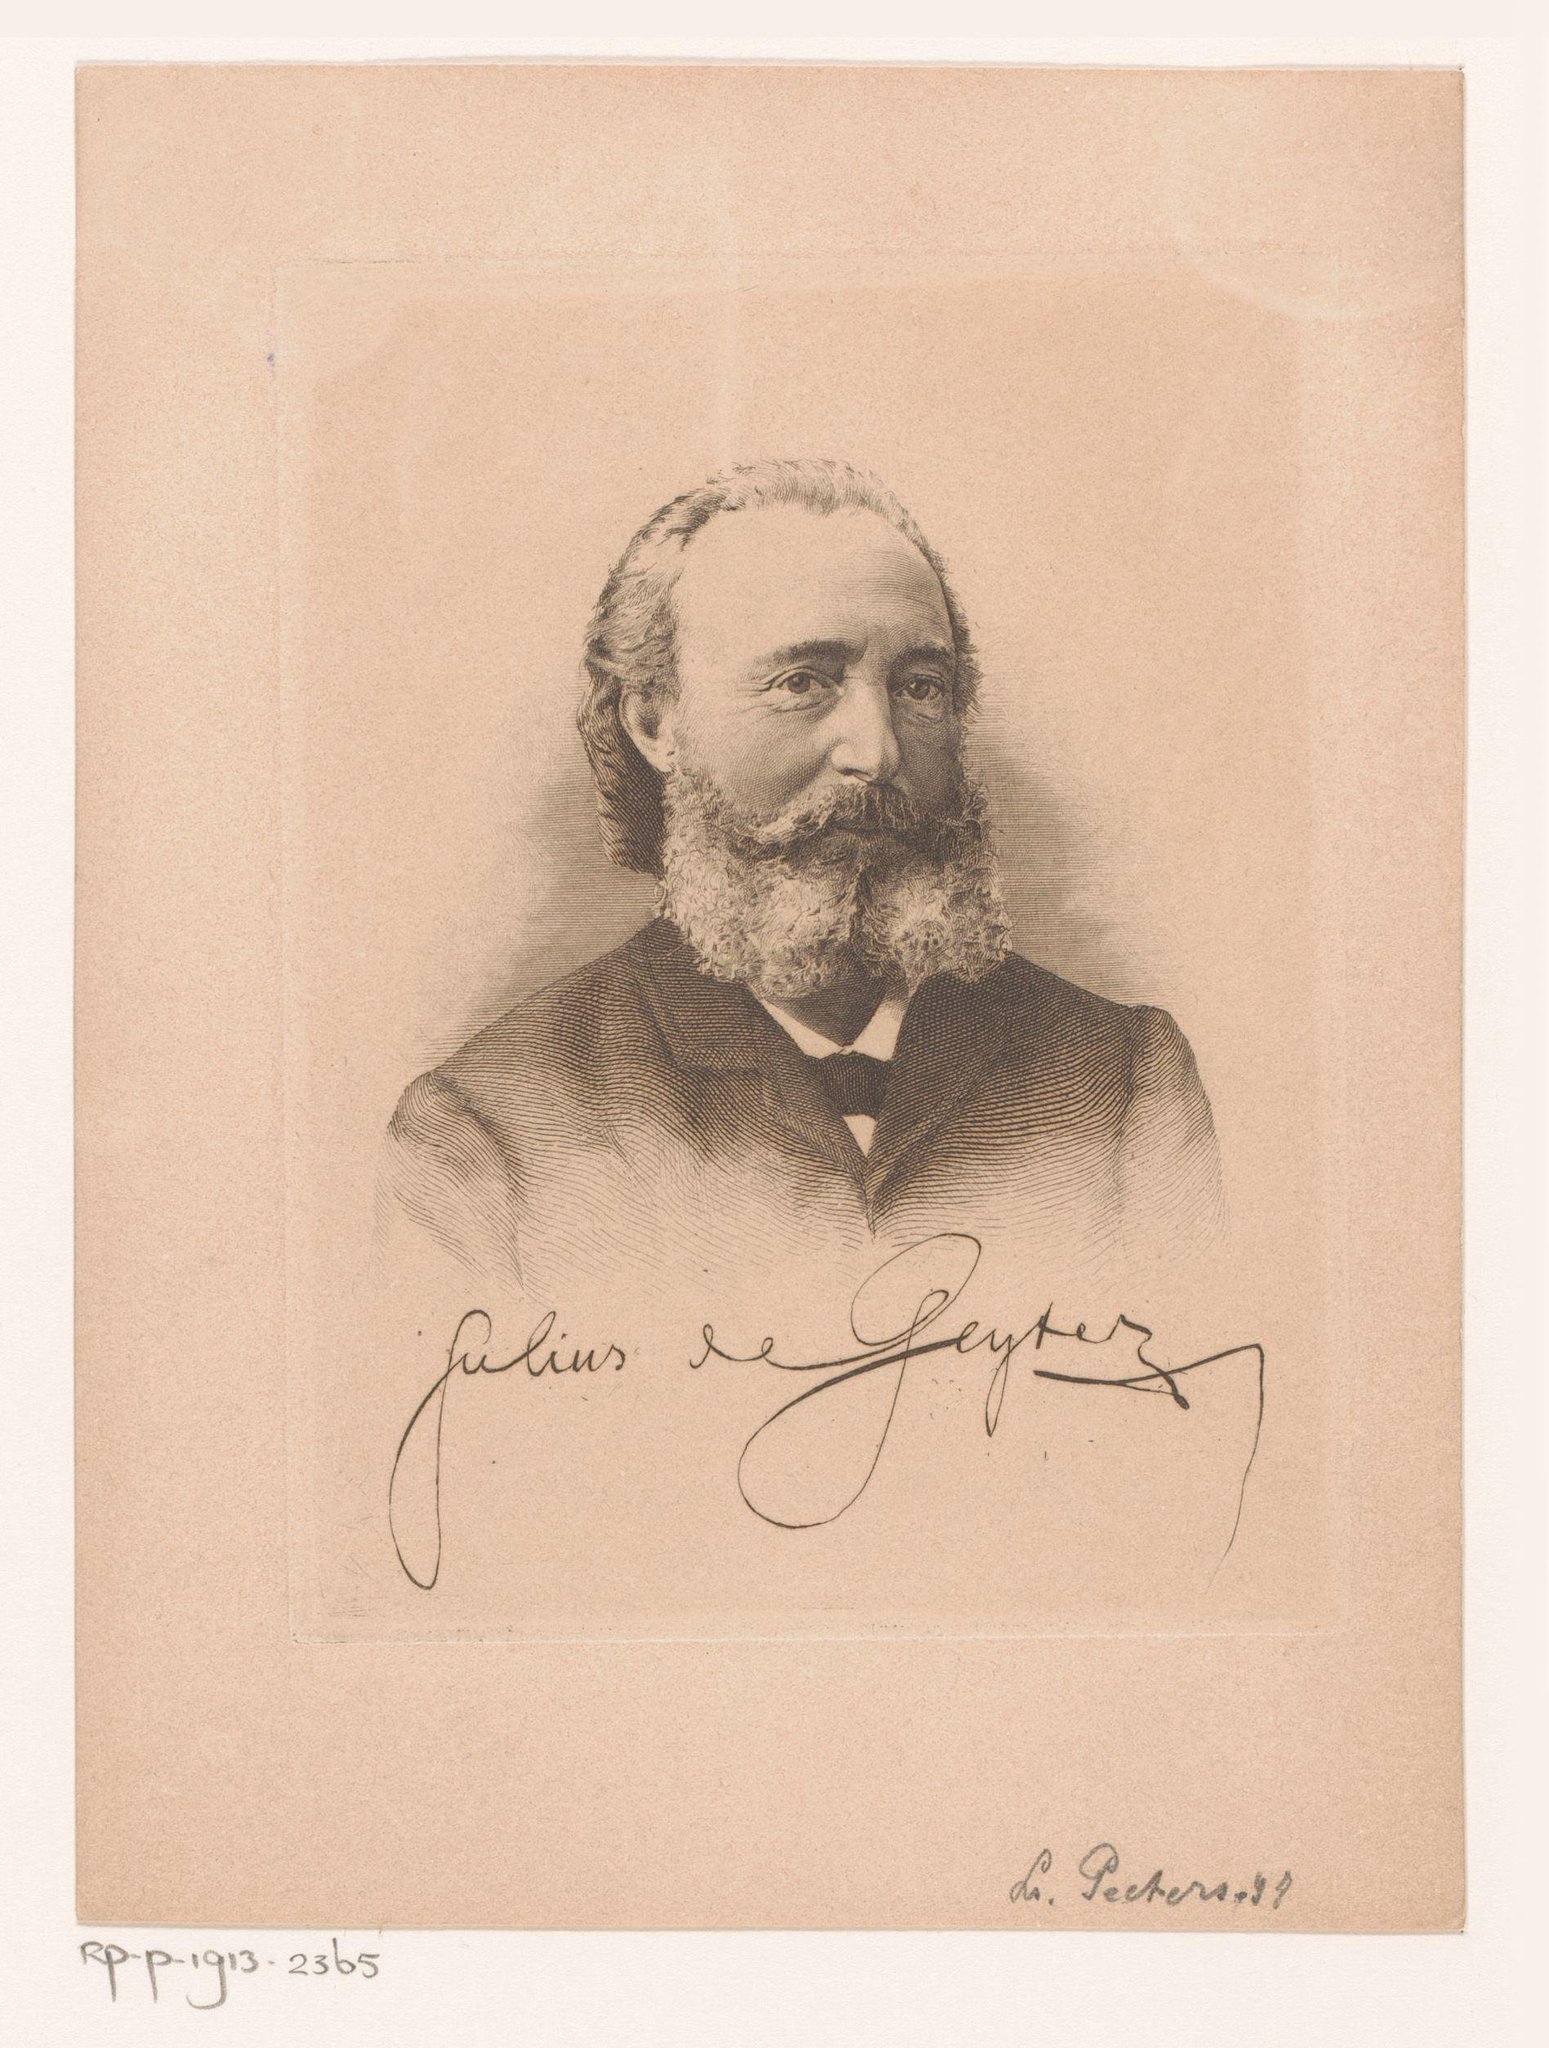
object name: print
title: Portret van Julius de Geyter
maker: louis peeters (i)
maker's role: print maker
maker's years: 1876-1964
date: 1897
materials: paper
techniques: etching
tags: historical persons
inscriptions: collector's mark: Lugt 2228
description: Geboorte- en sterfdatum van de prentmaker zijn onbekend. Daarom is voor de bepaling van de rechten van dit object gebruik gemaakt van de verwervingsdatum Rijksmuseum Amsterdam.